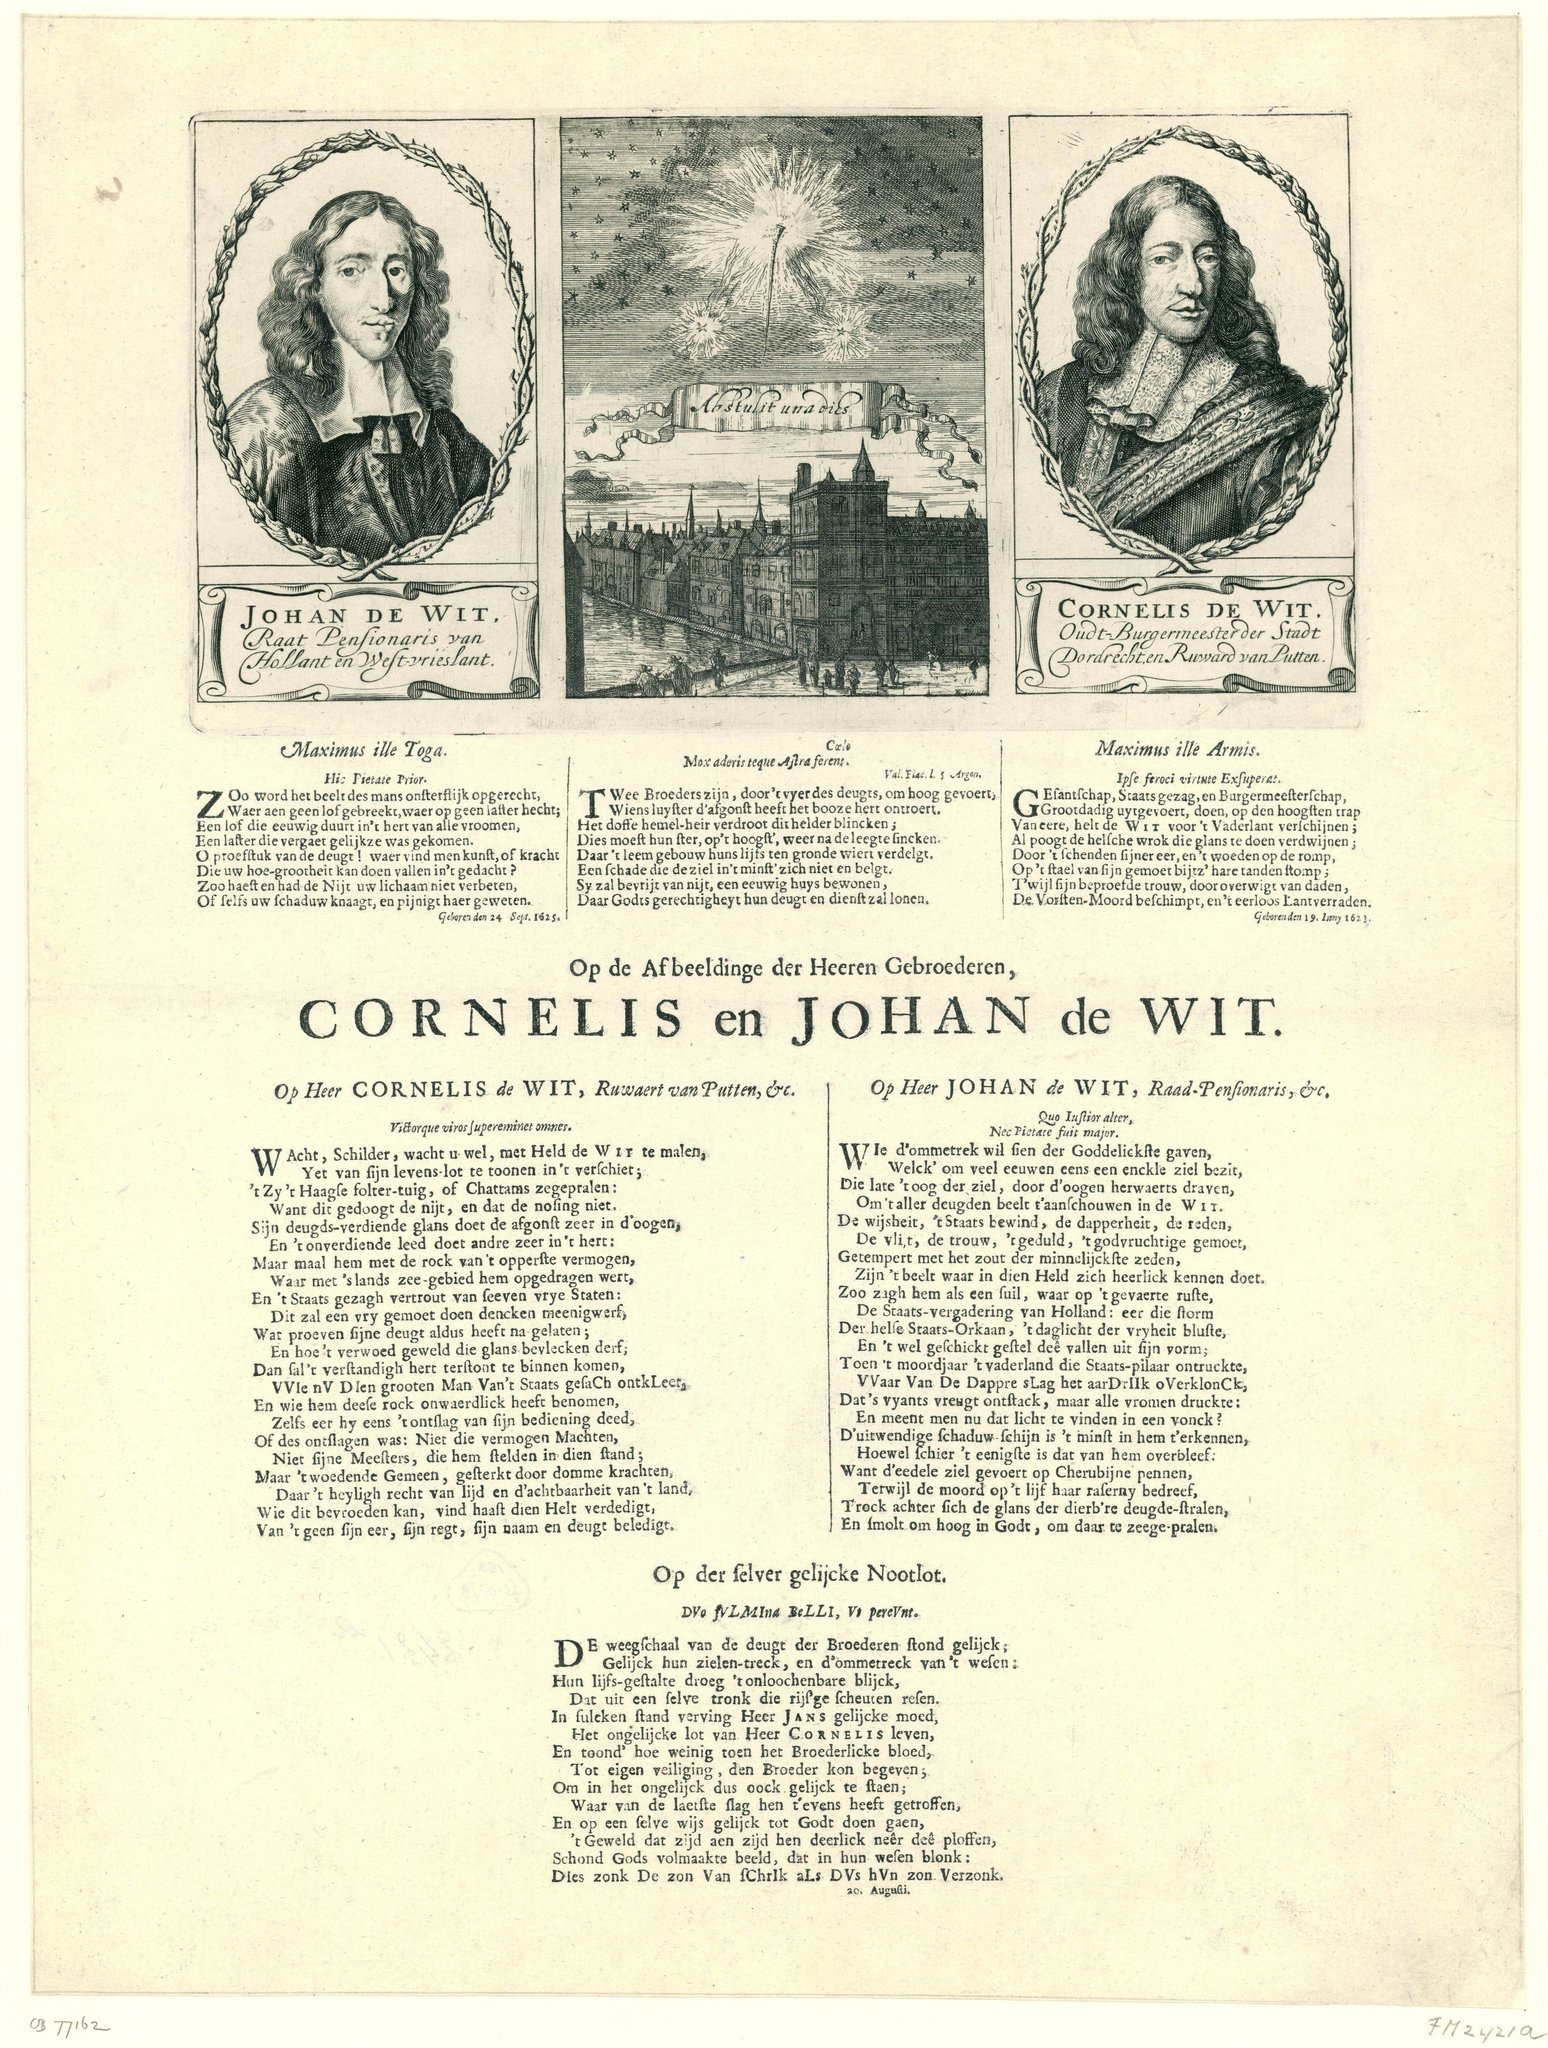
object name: print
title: Op de Afbeeldinge der Heeren Gebroederen, Cornelis en Johan de Wit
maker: Anonymous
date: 1672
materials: paper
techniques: engraving, etching, letterpress printing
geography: northern netherlands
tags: dordrecht, the hague, cornelis de witt, politician, johan de witt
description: Blad over de gebroeders De Witt. Bovenaan de portretten van Johan en Cornelis de Witt aan weerszijden van een voorstelling van twee schitterende sterren die boven 's-Gravenhage aan de hemel verschenen. Hieronder deze voorstellingen staan drie korte verzen. Deze prent is gedrukt van dezelfde plaat als FMH 2420a, maar alleen het portret van Johan de Witt is onveranderd gebleven. Het portret van Cornelis en het gezicht op het Buitenhof zijn nieuw. Onder de titel verzen op Cornelis en Johan de Witt en hun identieke noodlot. Dit blad verscheen ter verdediging van de gebroeders De Witt.